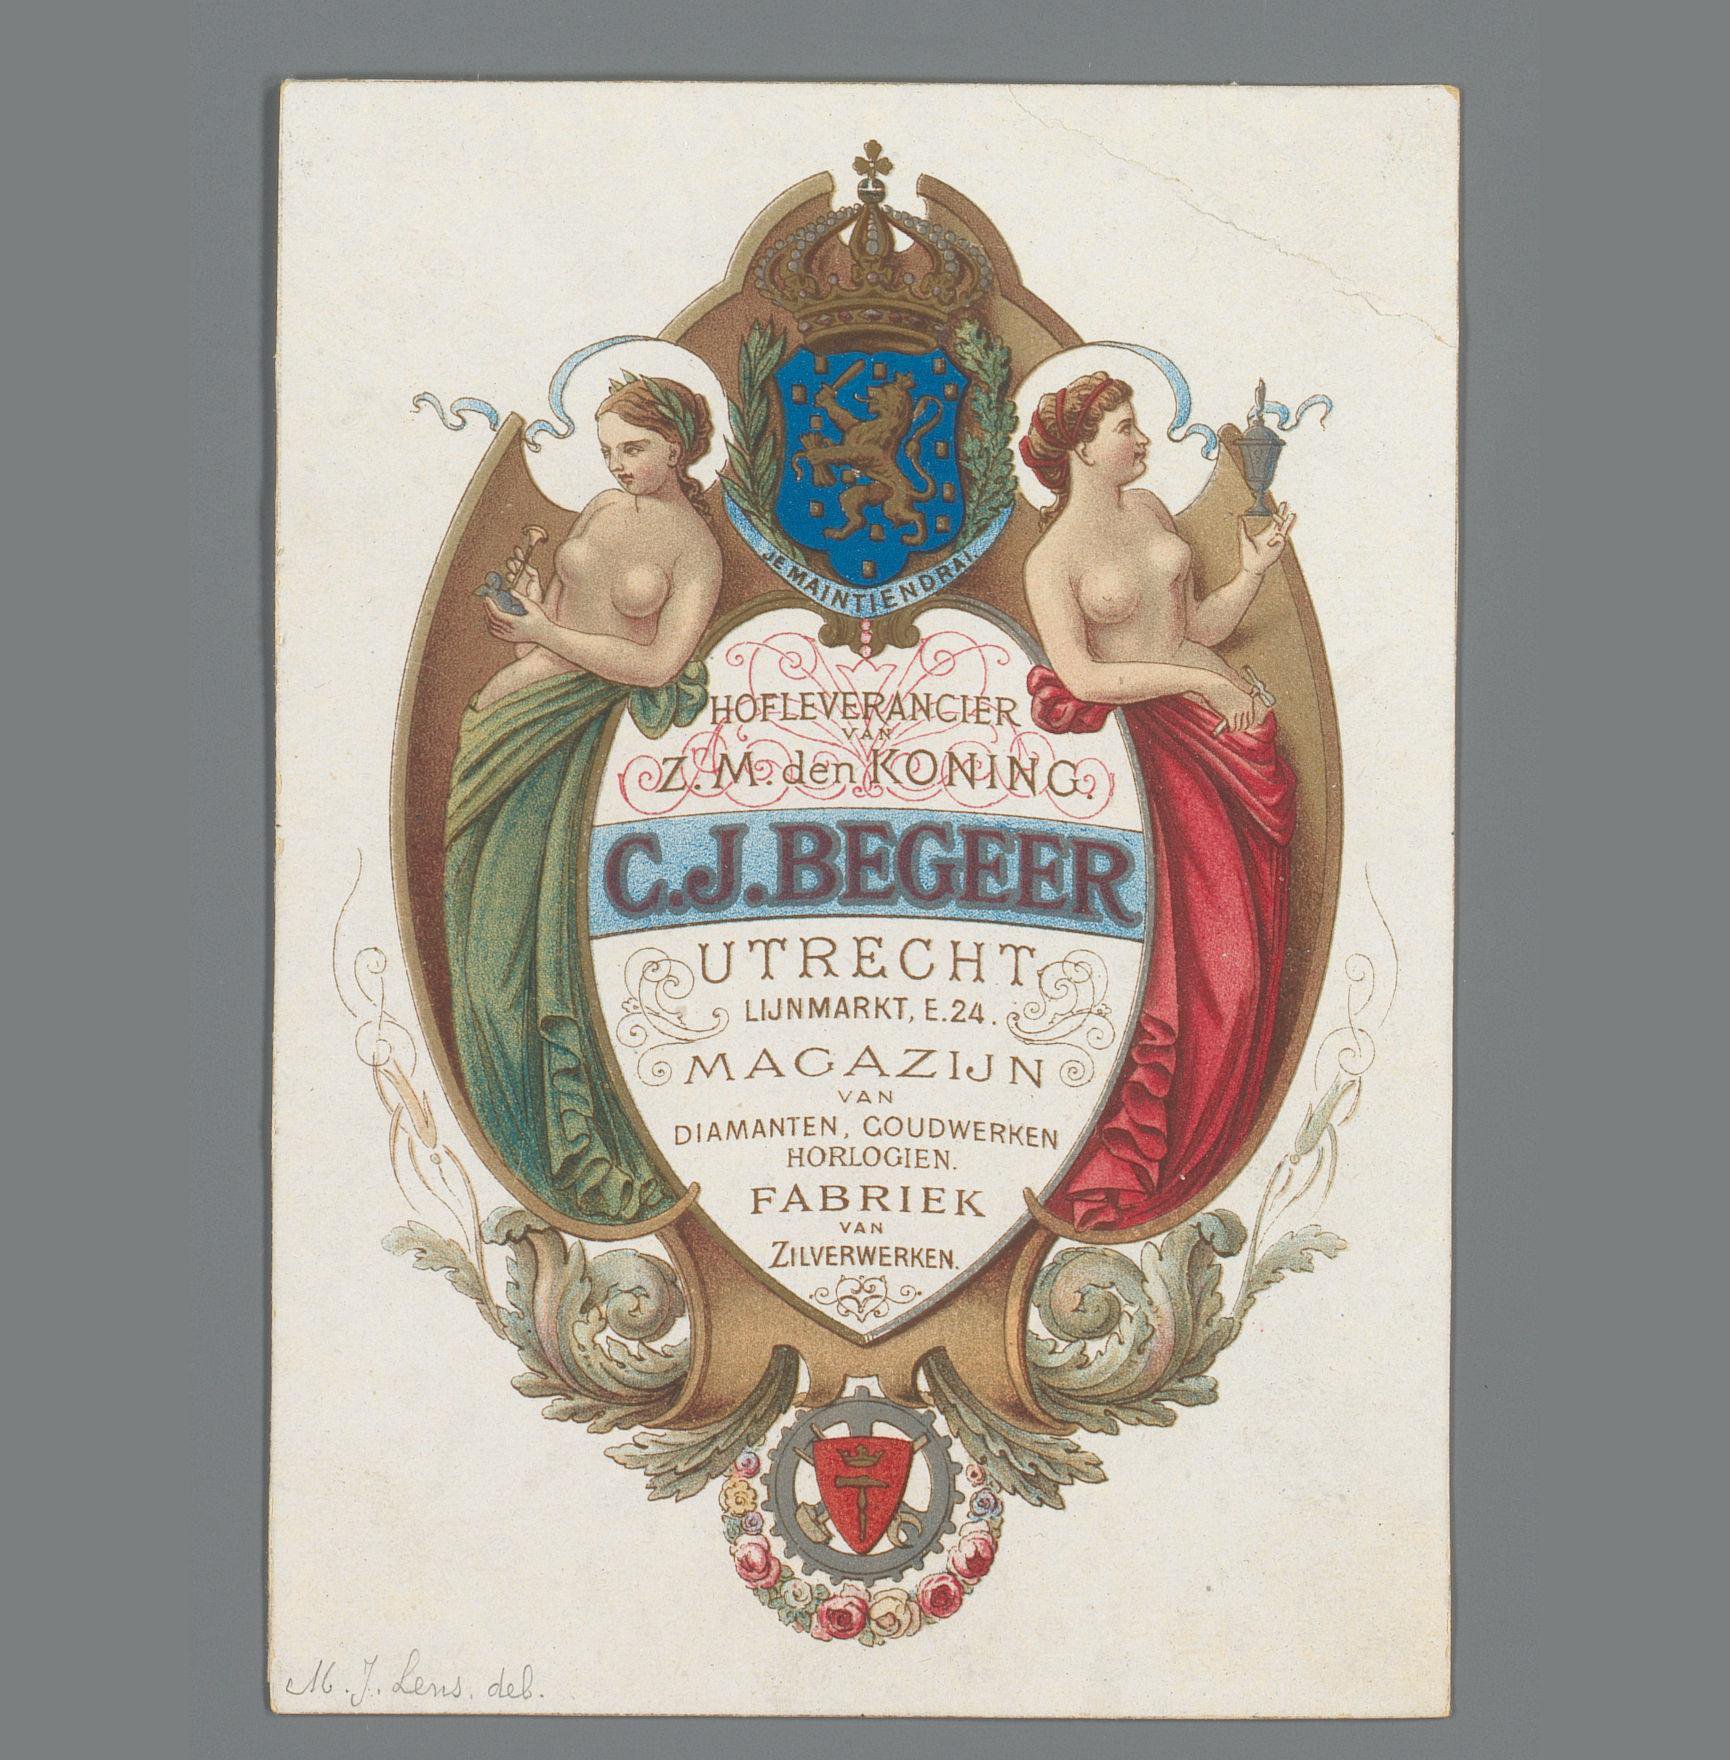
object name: visiting card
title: Visitekaart voor juwelier C.J. Begeer in Utrecht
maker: maurits johannes lens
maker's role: designer, draughtsman, print maker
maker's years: 1829-1897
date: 1839-1897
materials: paper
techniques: chromolithography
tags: visiting-card, calling-card, utrecht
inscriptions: collector's mark: Lugt 2760, collector's mark: Lugt 2228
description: Twee vrouwen met ontbloot bovenlijf aan weerszijden van een schild met daarop de tekst 'Hofleverancier van Z.M. den Koning C.J. Begeer Utrecht (...)'.